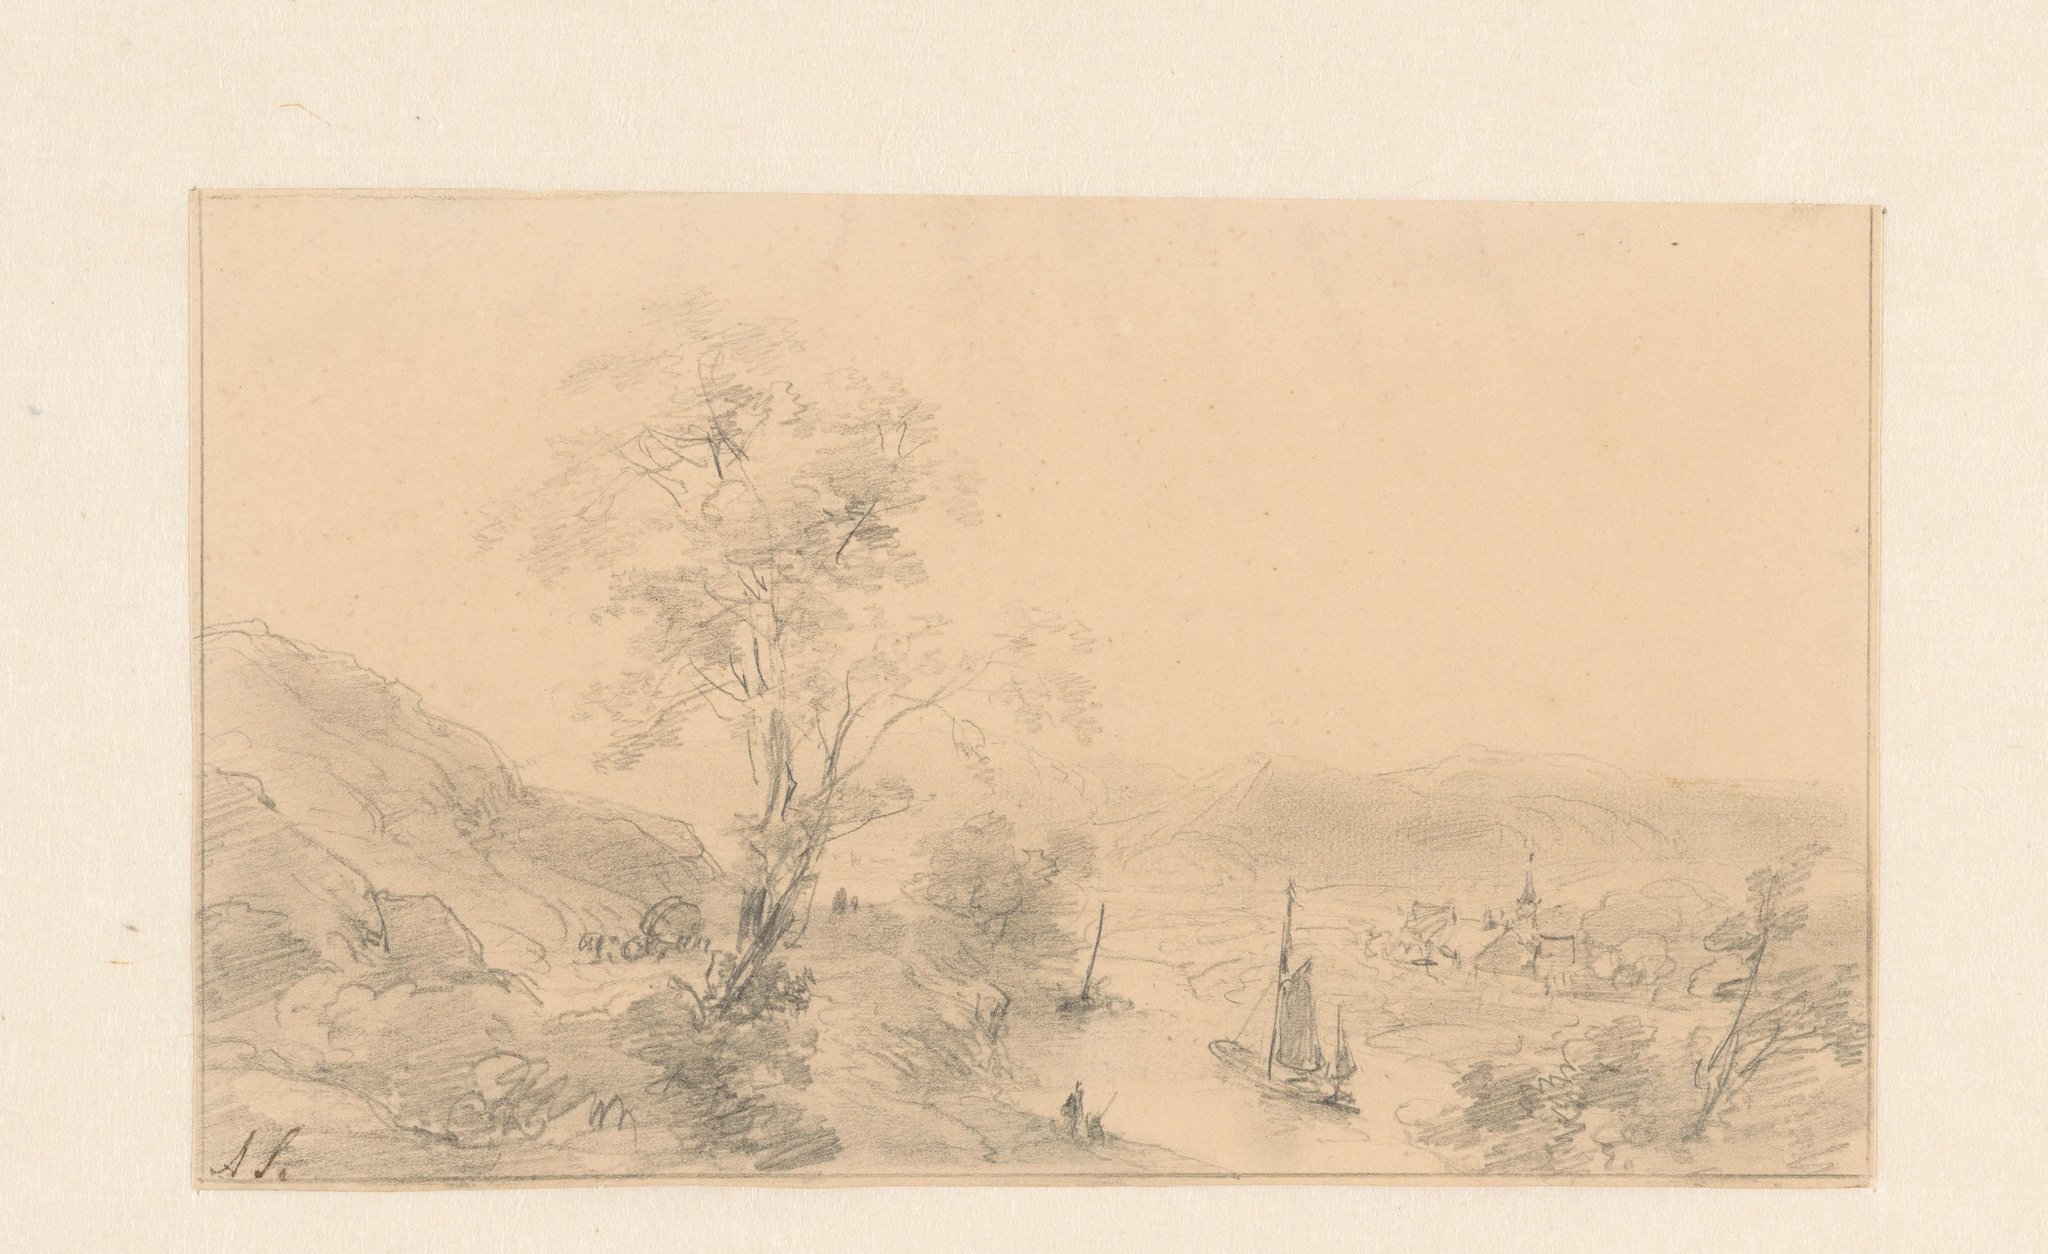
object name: drawing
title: Bergachtige landschap met rivier en dorpje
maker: andreas schelfhout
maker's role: draughtsman, painter, print maker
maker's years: 1787-1870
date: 1797-1870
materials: paper, pencil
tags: river, village, mountains